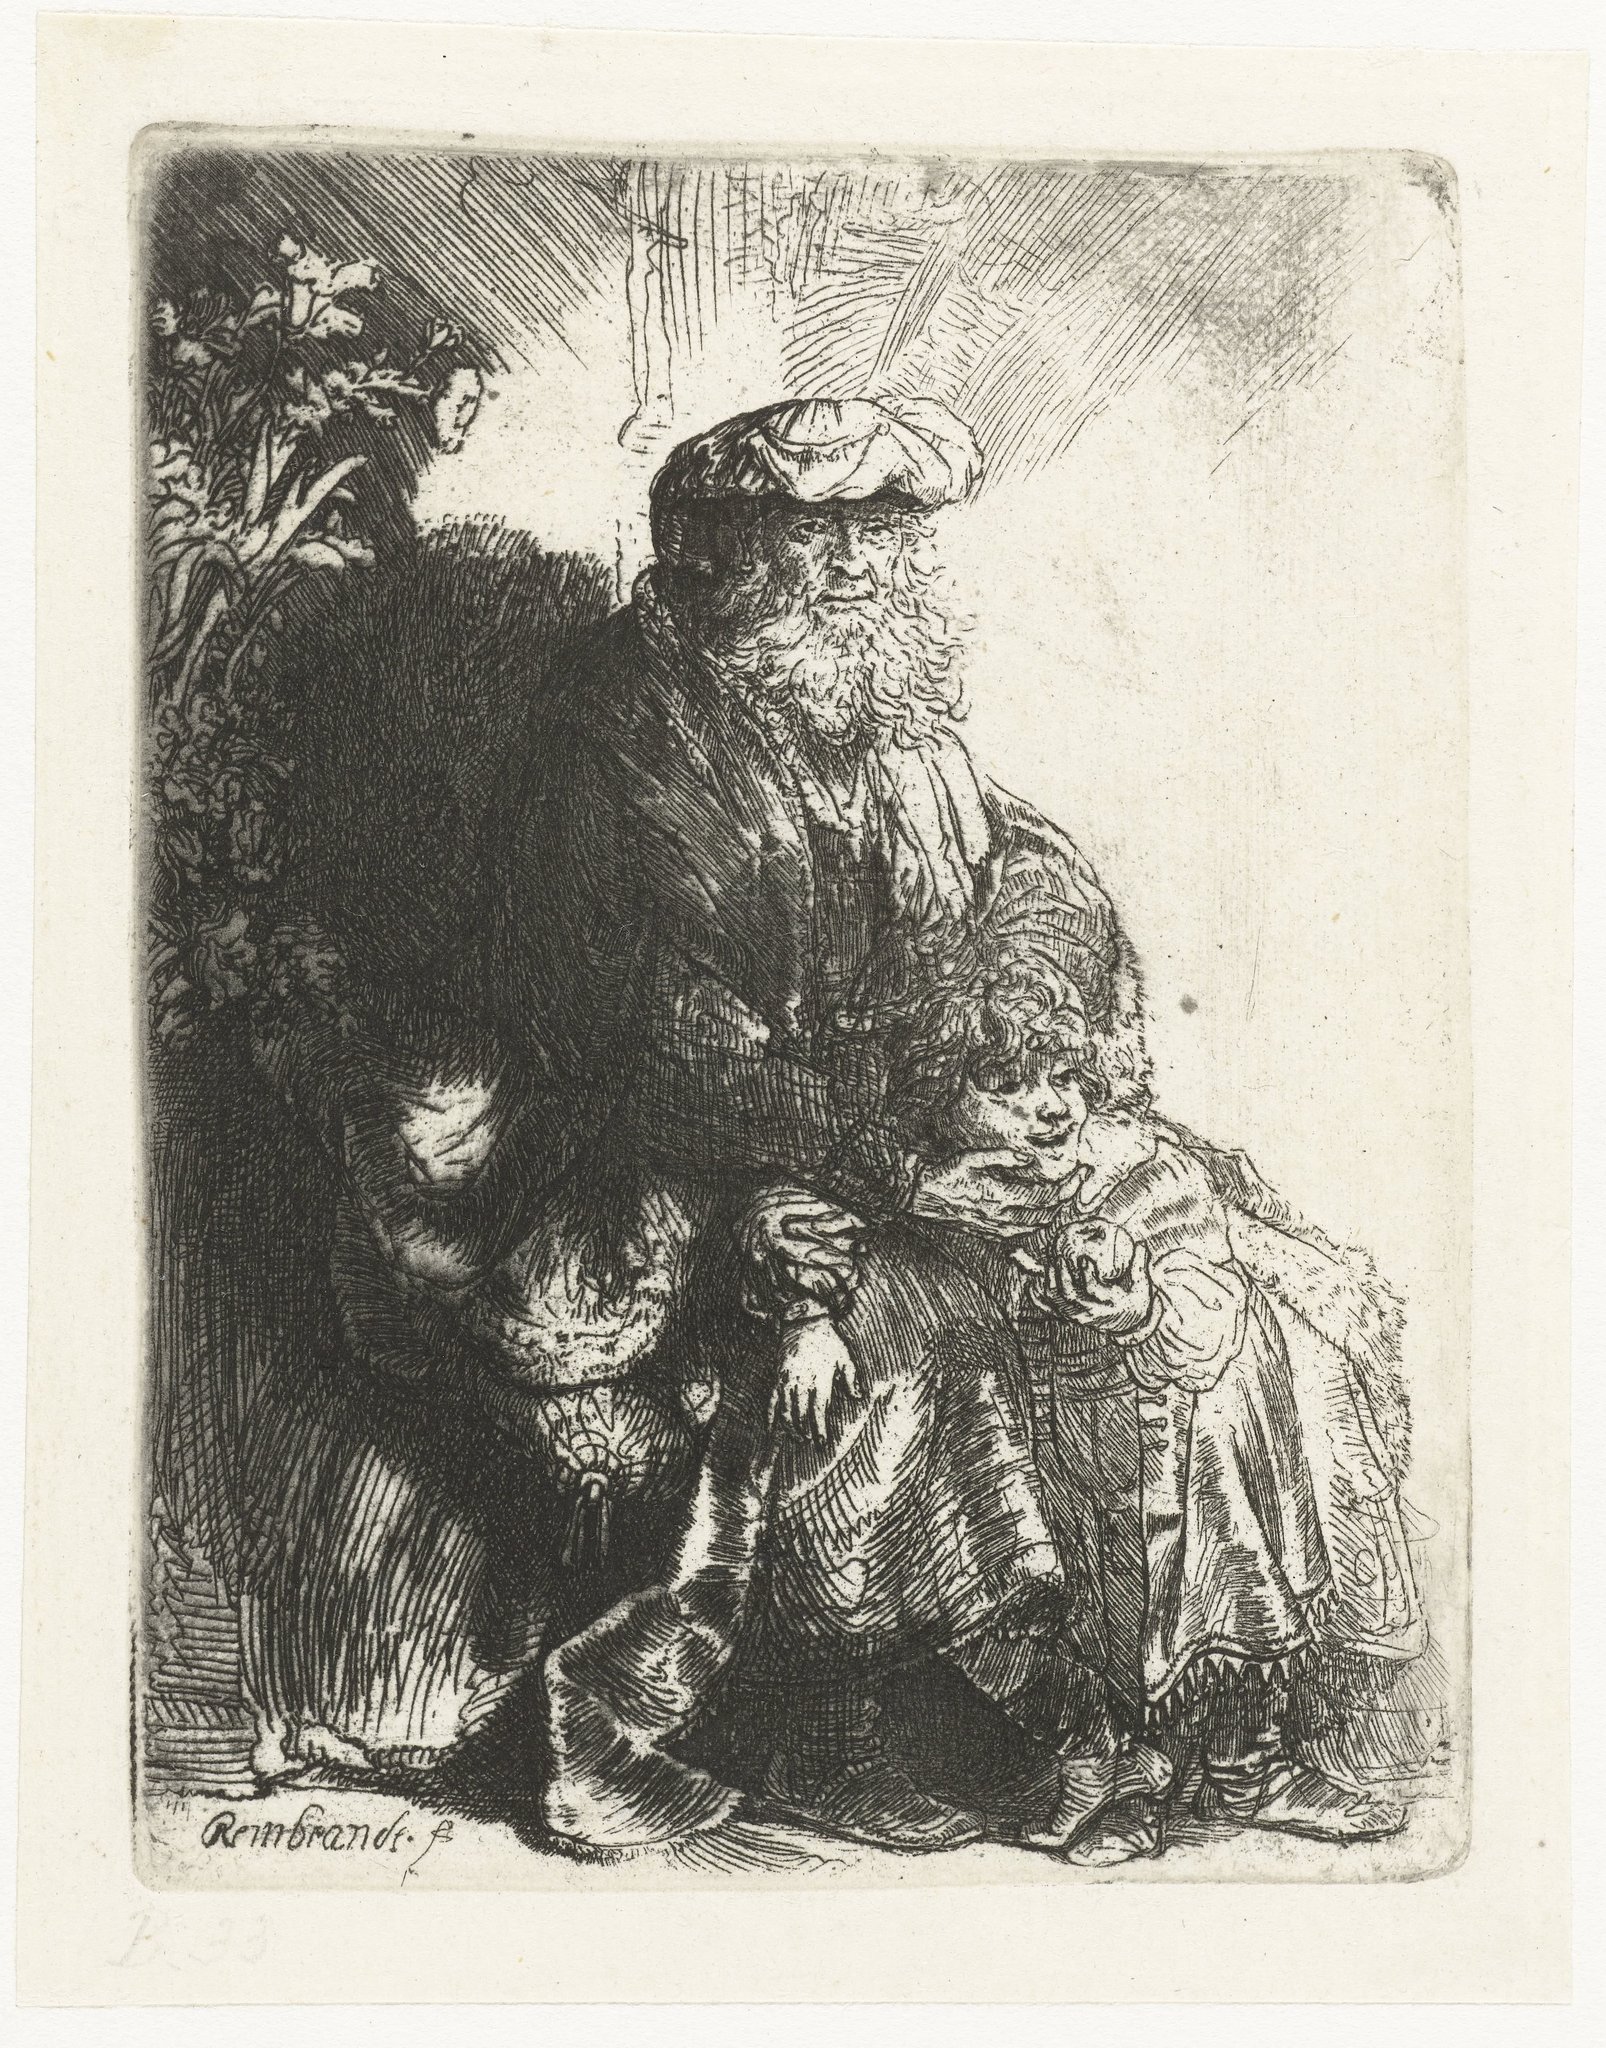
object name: print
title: Jacob caressing Benjamin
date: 1850-1906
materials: paper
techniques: etching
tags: the missing cup ~ story of joseph (genesis 44-45)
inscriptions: inscription: ‘Coppier’, signature: ‘Rembandt f.’